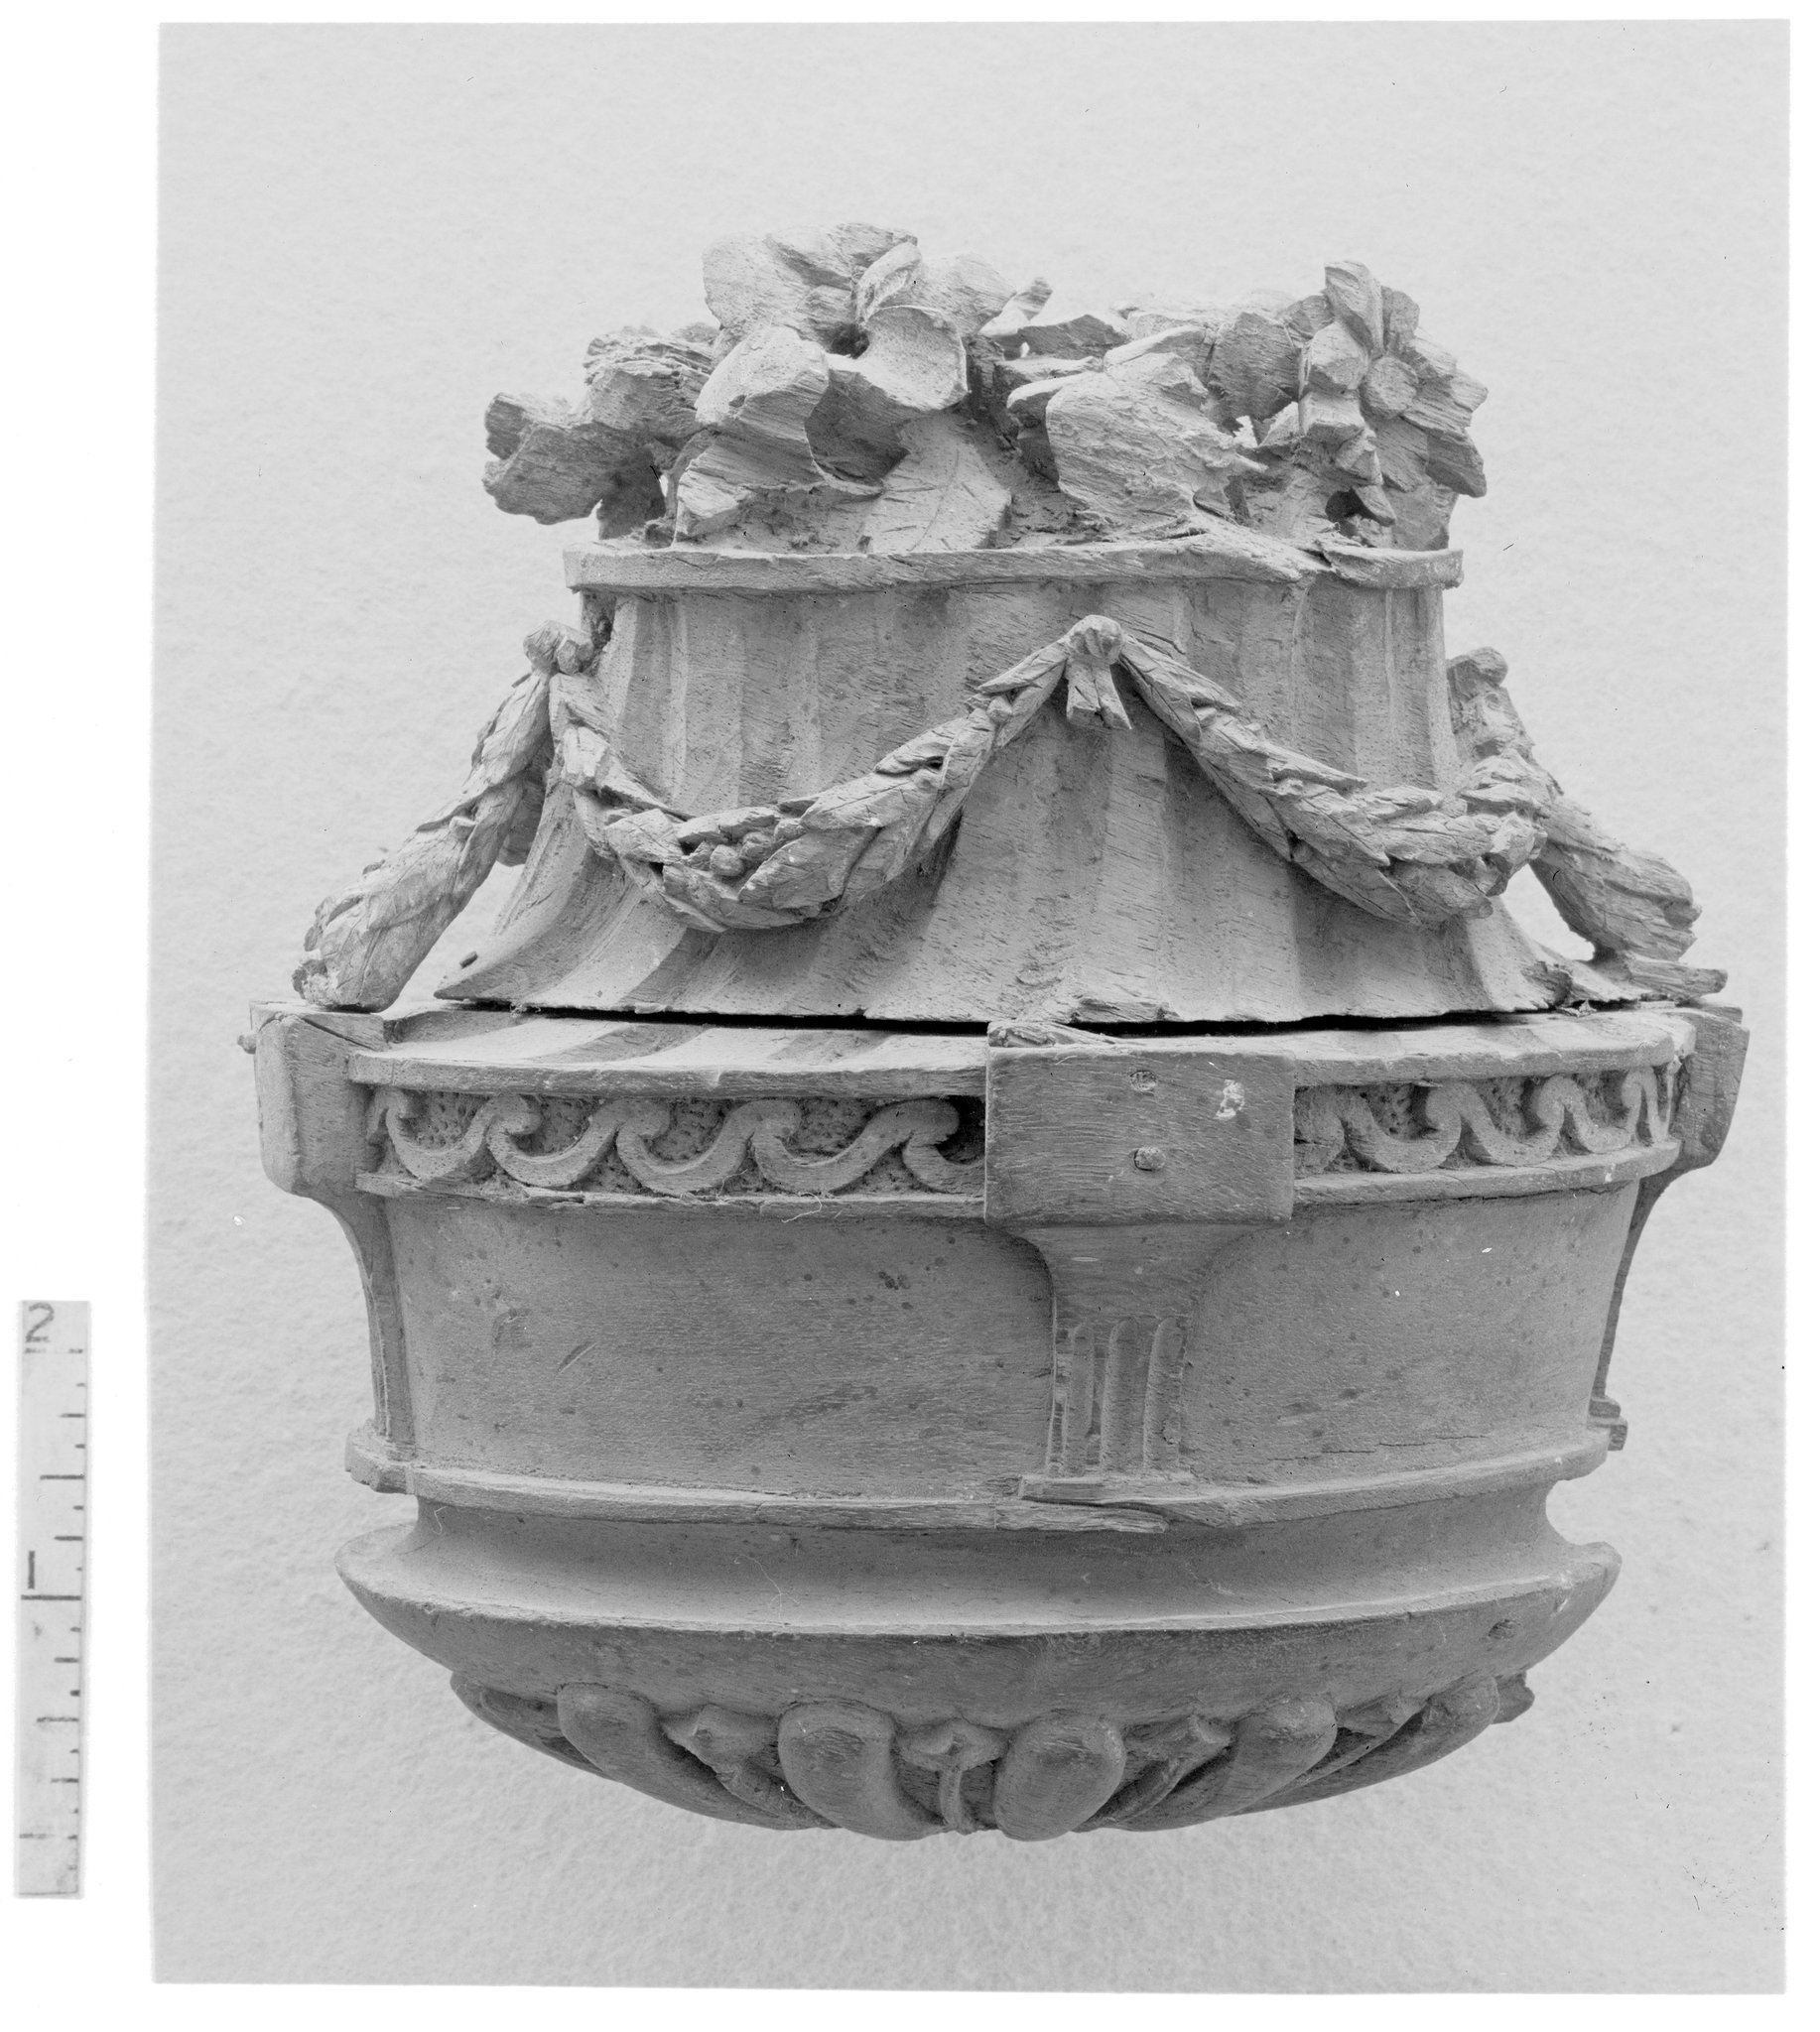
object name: vase detail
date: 1701-1800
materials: wood